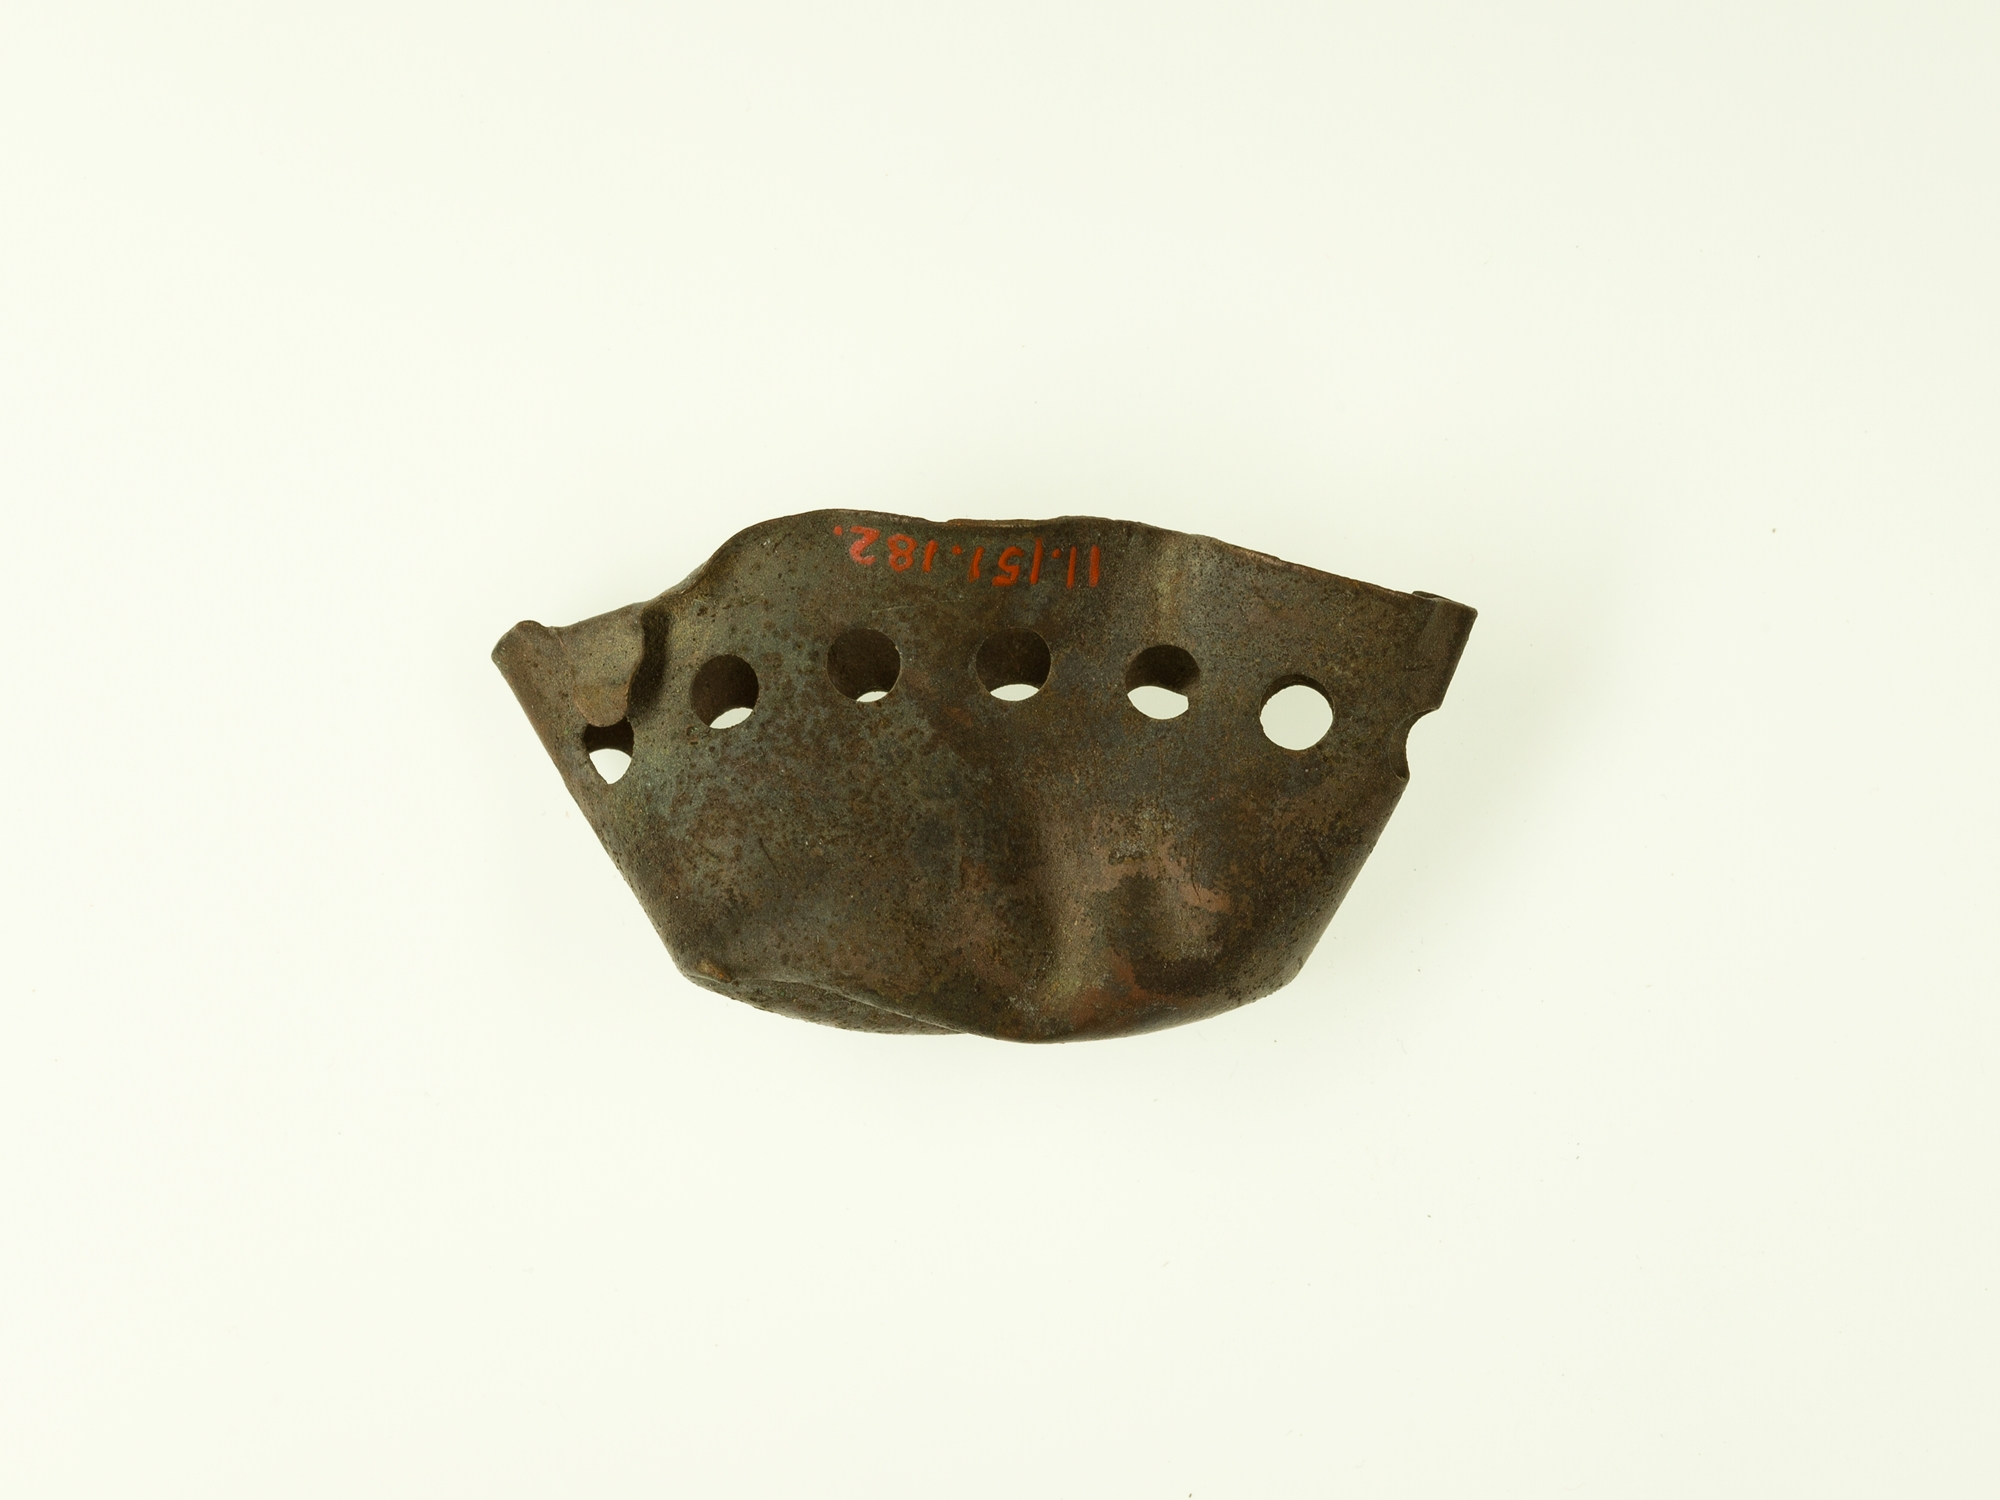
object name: cup fragment, flattened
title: Flattened cup fragment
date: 1295-1070 BCE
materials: bronze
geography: egypt